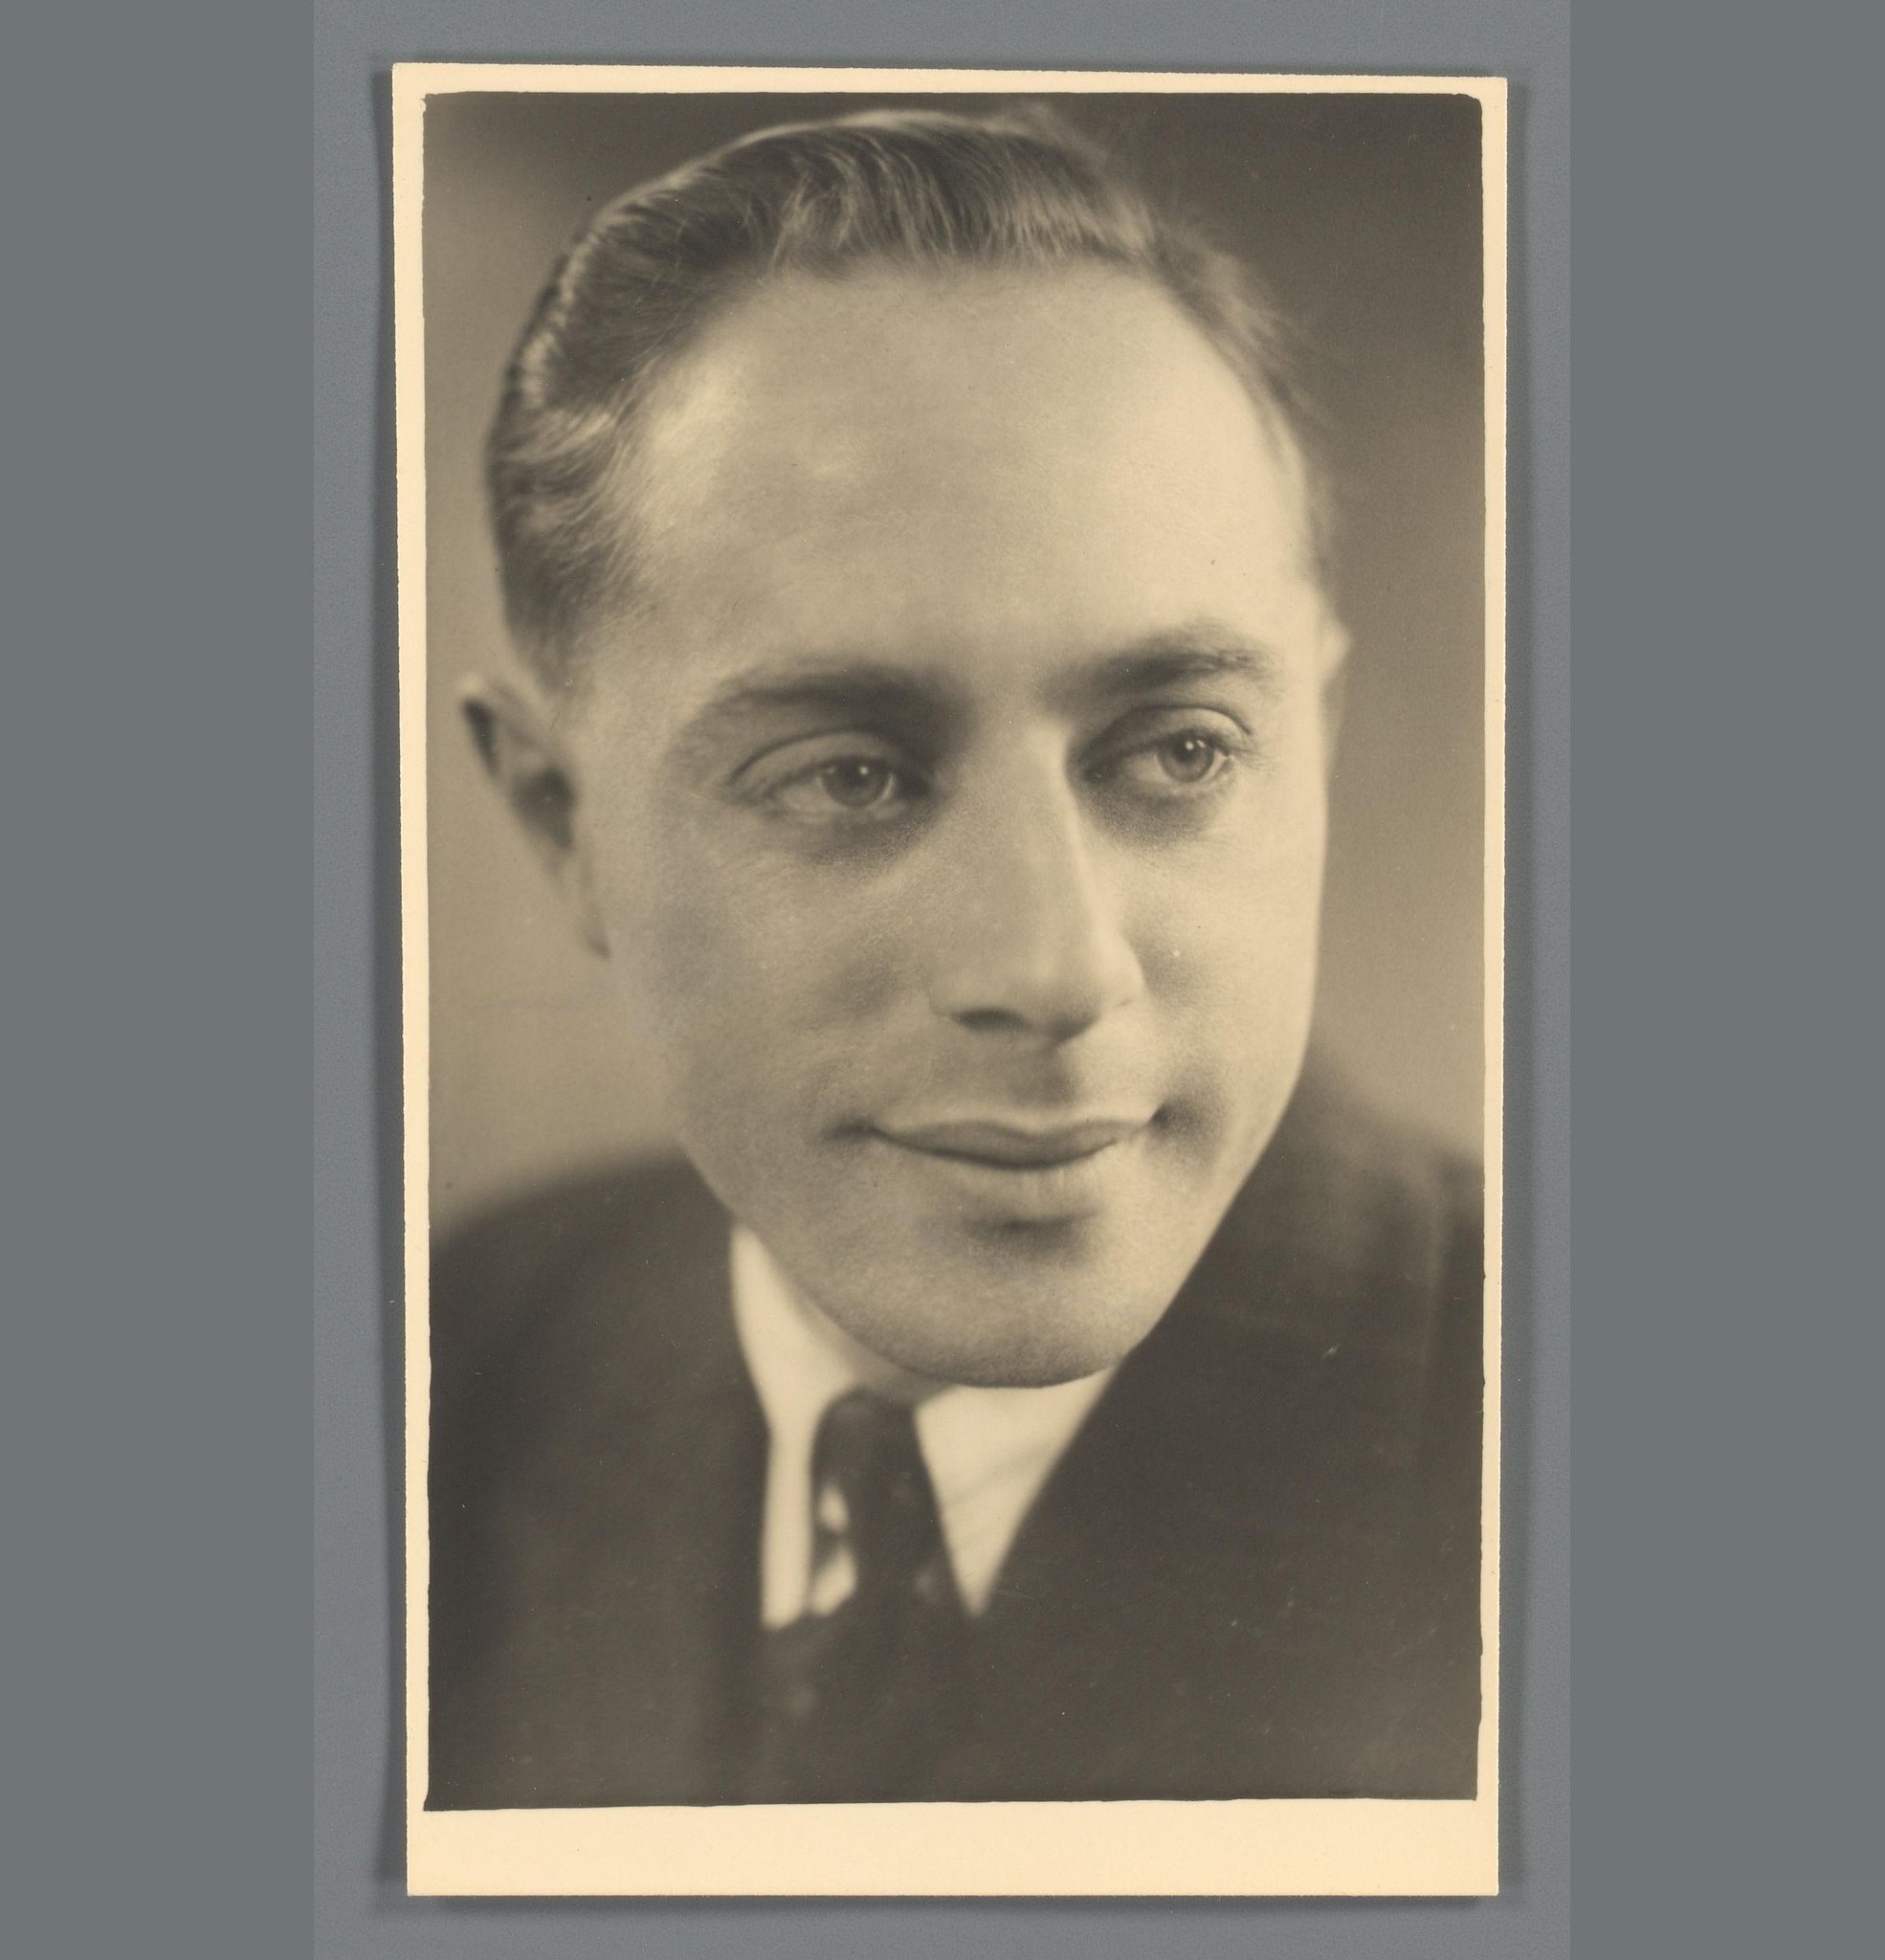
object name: photograph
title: Portret van een onbekende jongeman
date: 1945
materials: paper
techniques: gelatin silver print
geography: the hague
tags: historical persons not known by name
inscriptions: date: ‘23 Nov. 1945’, stamp: ‘Gordon Studios/ Spuistraat 68/ Den Haag’